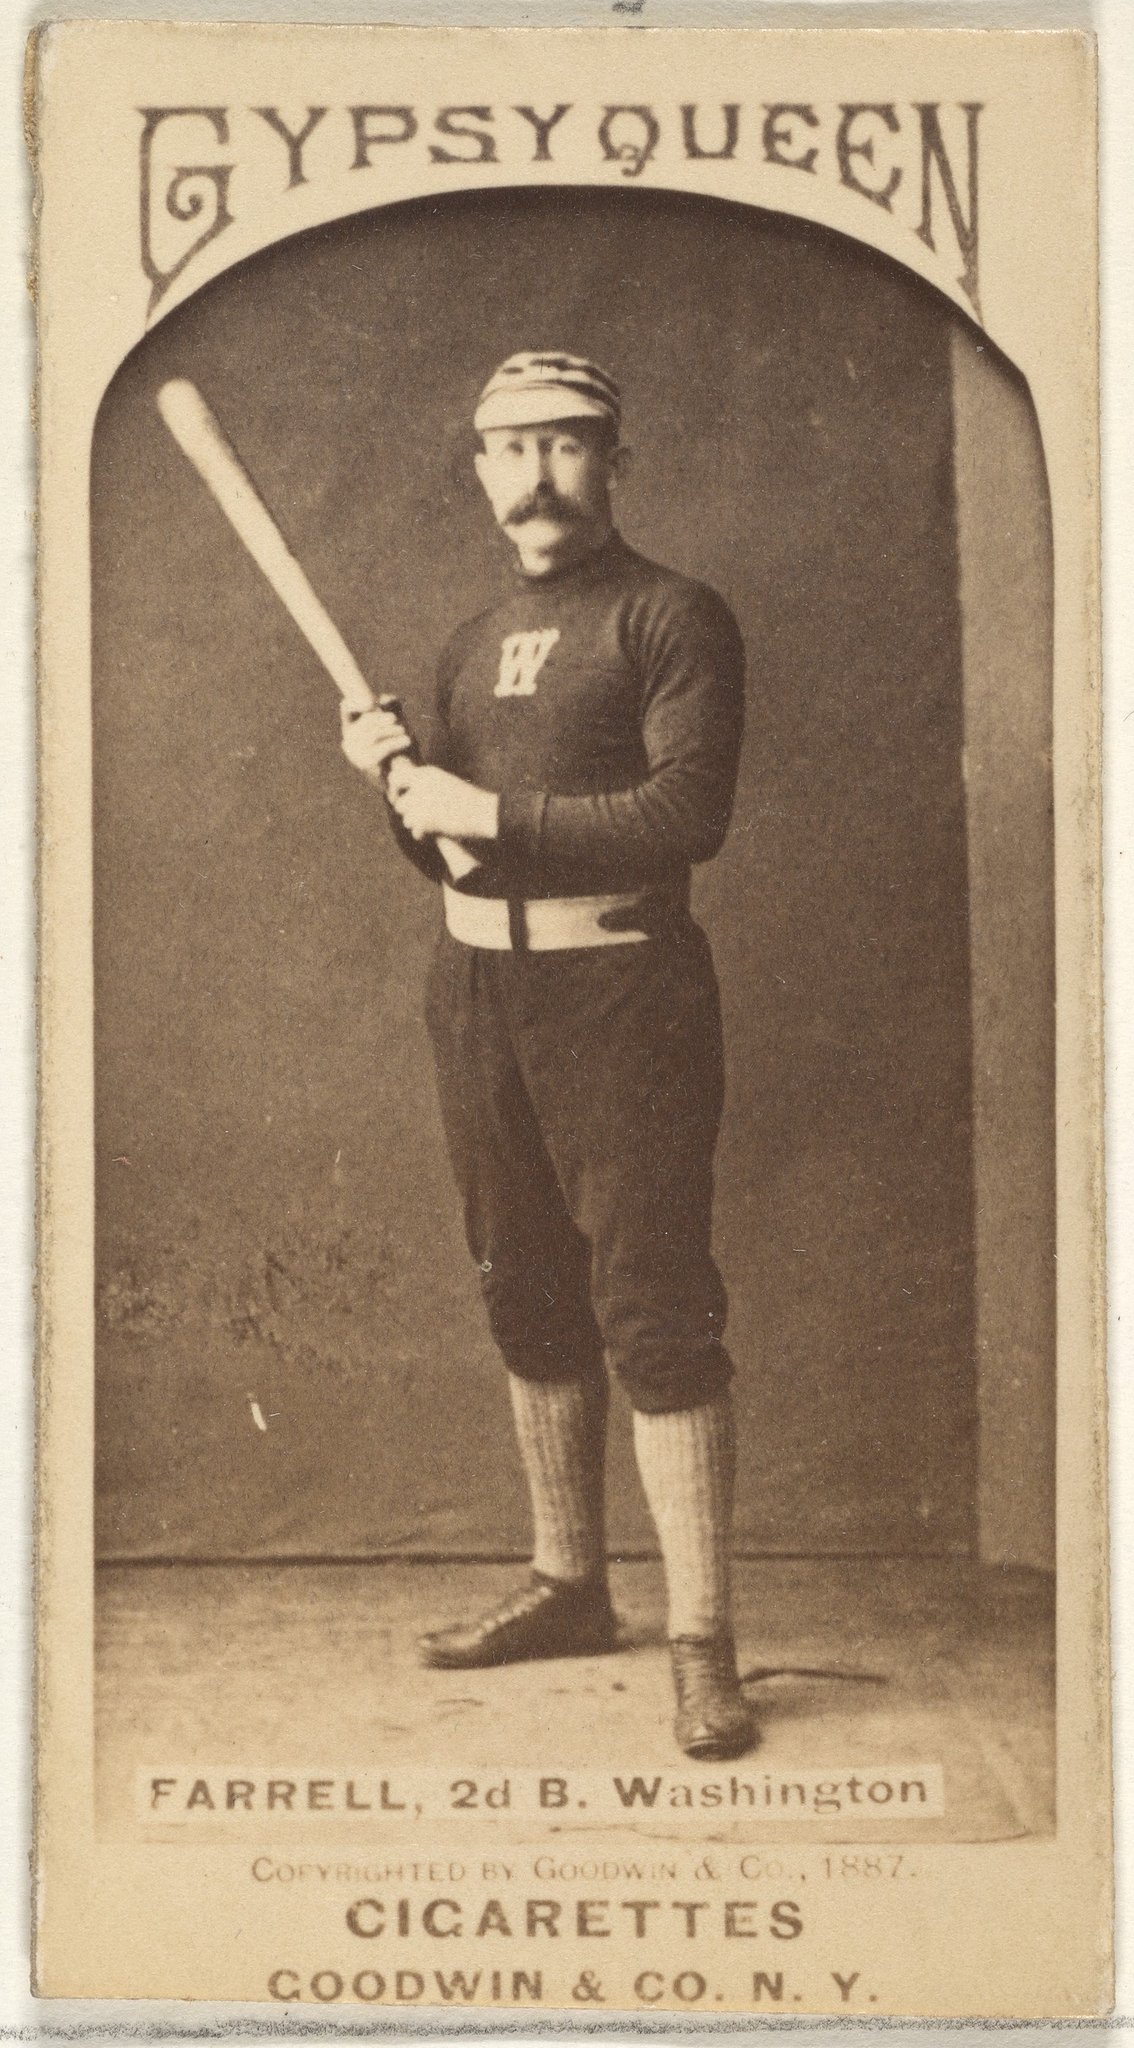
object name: baseball card, photograph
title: John A. "Jack" Farrell, 2nd Base, Washington Nationals, from the Old Judge series (N172) for Old Judge and Gypsy Queen Cigarettes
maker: goodwin & company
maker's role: publisher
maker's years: 1850-1950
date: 1887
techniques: albumen silver print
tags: men,portraits,baseball,athletes